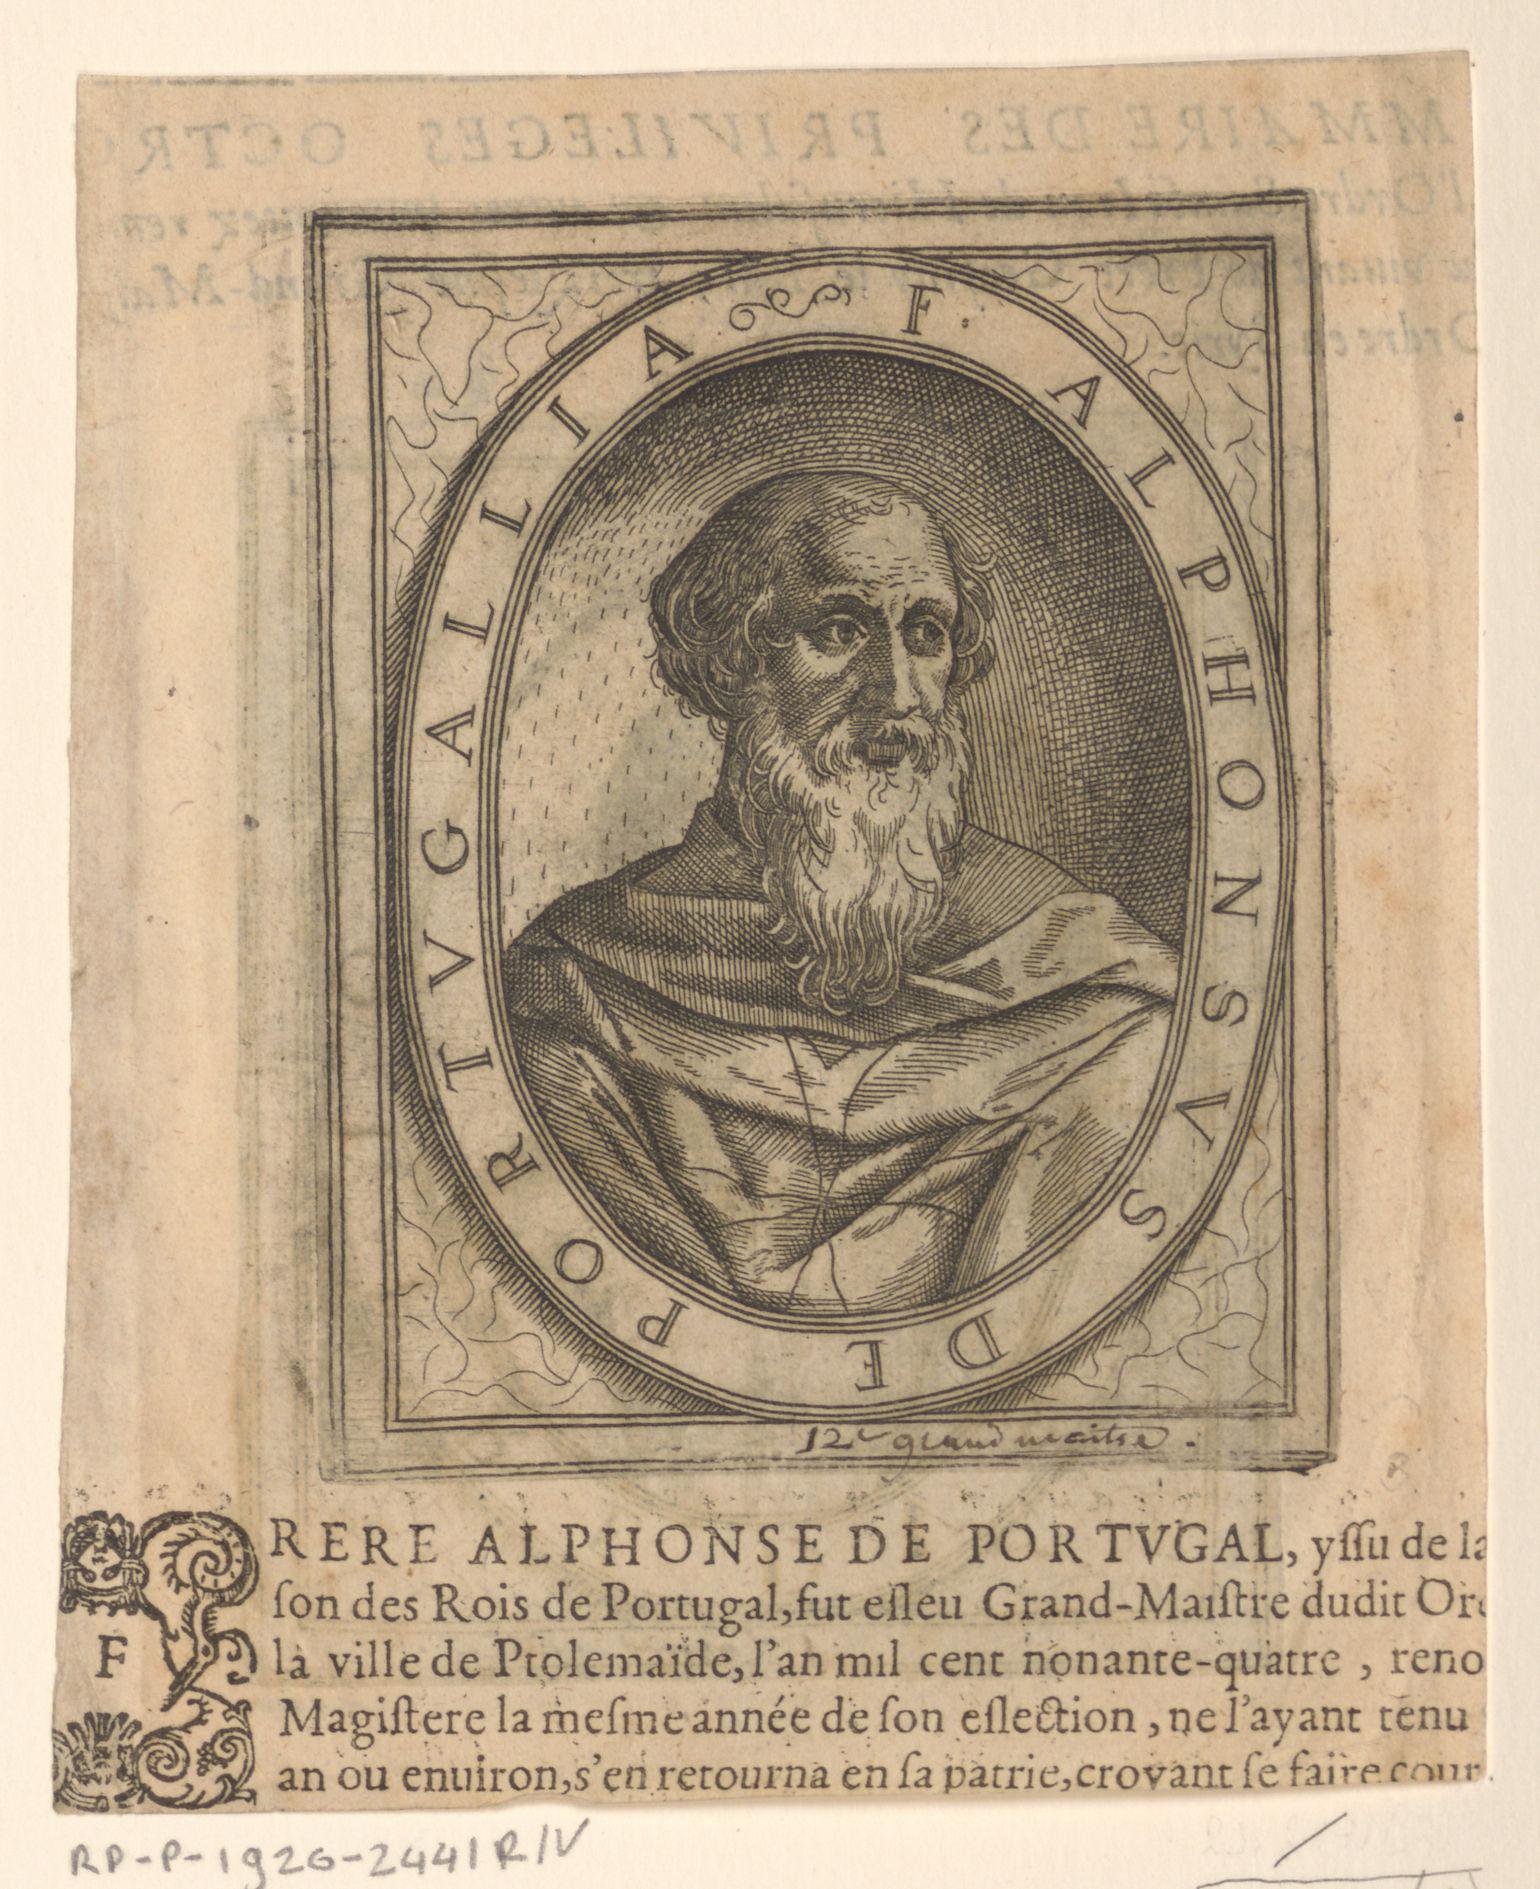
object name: print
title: Portret van Alfons van Portugal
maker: Anonymous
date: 1643-1659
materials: paper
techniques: engraving, etching, letterpress printing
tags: historical persons, military orders, e.g.: knights templars, knights of malta, teutonic knights ~ roman catholic church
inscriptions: inscription: ‘grand maitre’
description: Prent mogelijk uit: Baudoin, Jean. Histoire des chevaliers de l'ordre de s. Jean de Hierusalem (...). Parijs: Jacques Dallin, 1643. Of uit: Baudoin, Jean. Histoire des chevaliers de l'ordre de s. Jean de Hierusalem (...). Parijs: Thomas Jolly, 1659.